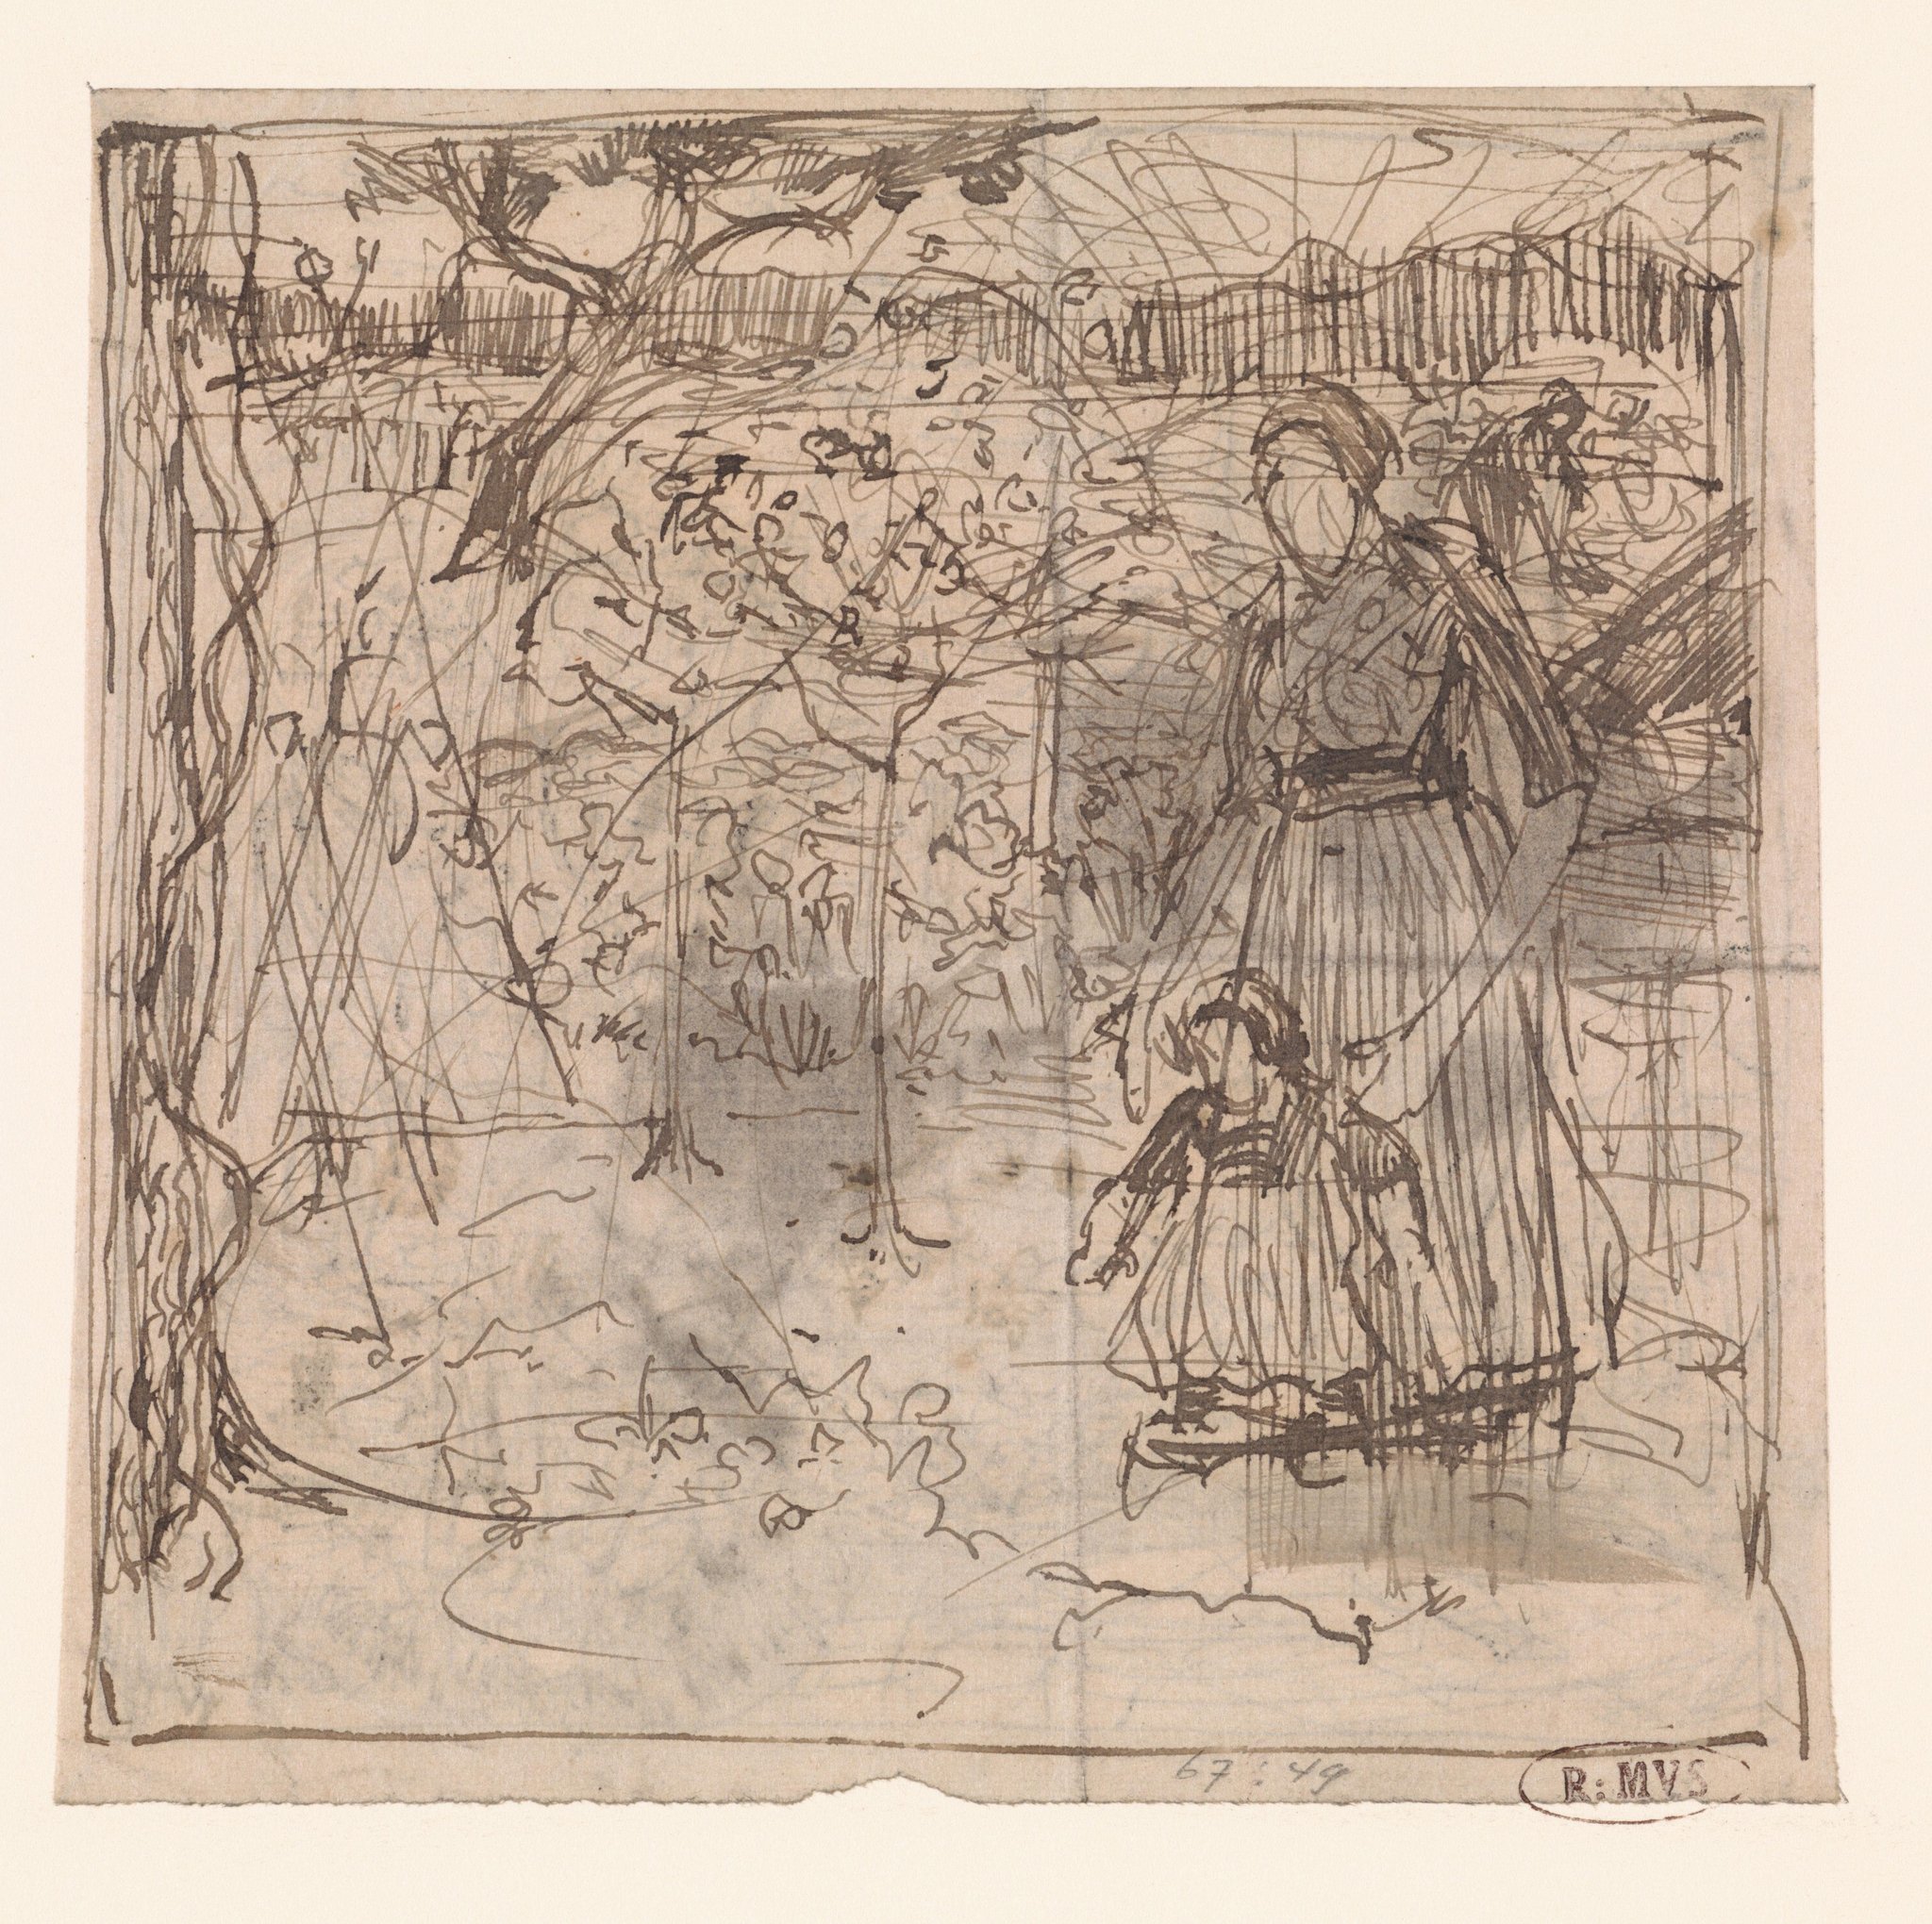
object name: drawing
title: Moeder met kind in een tuin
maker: edzard koning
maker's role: draughtsman, print maker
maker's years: 1869-1954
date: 1879-1954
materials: ink, paper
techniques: pen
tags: garden, mother and baby or young child